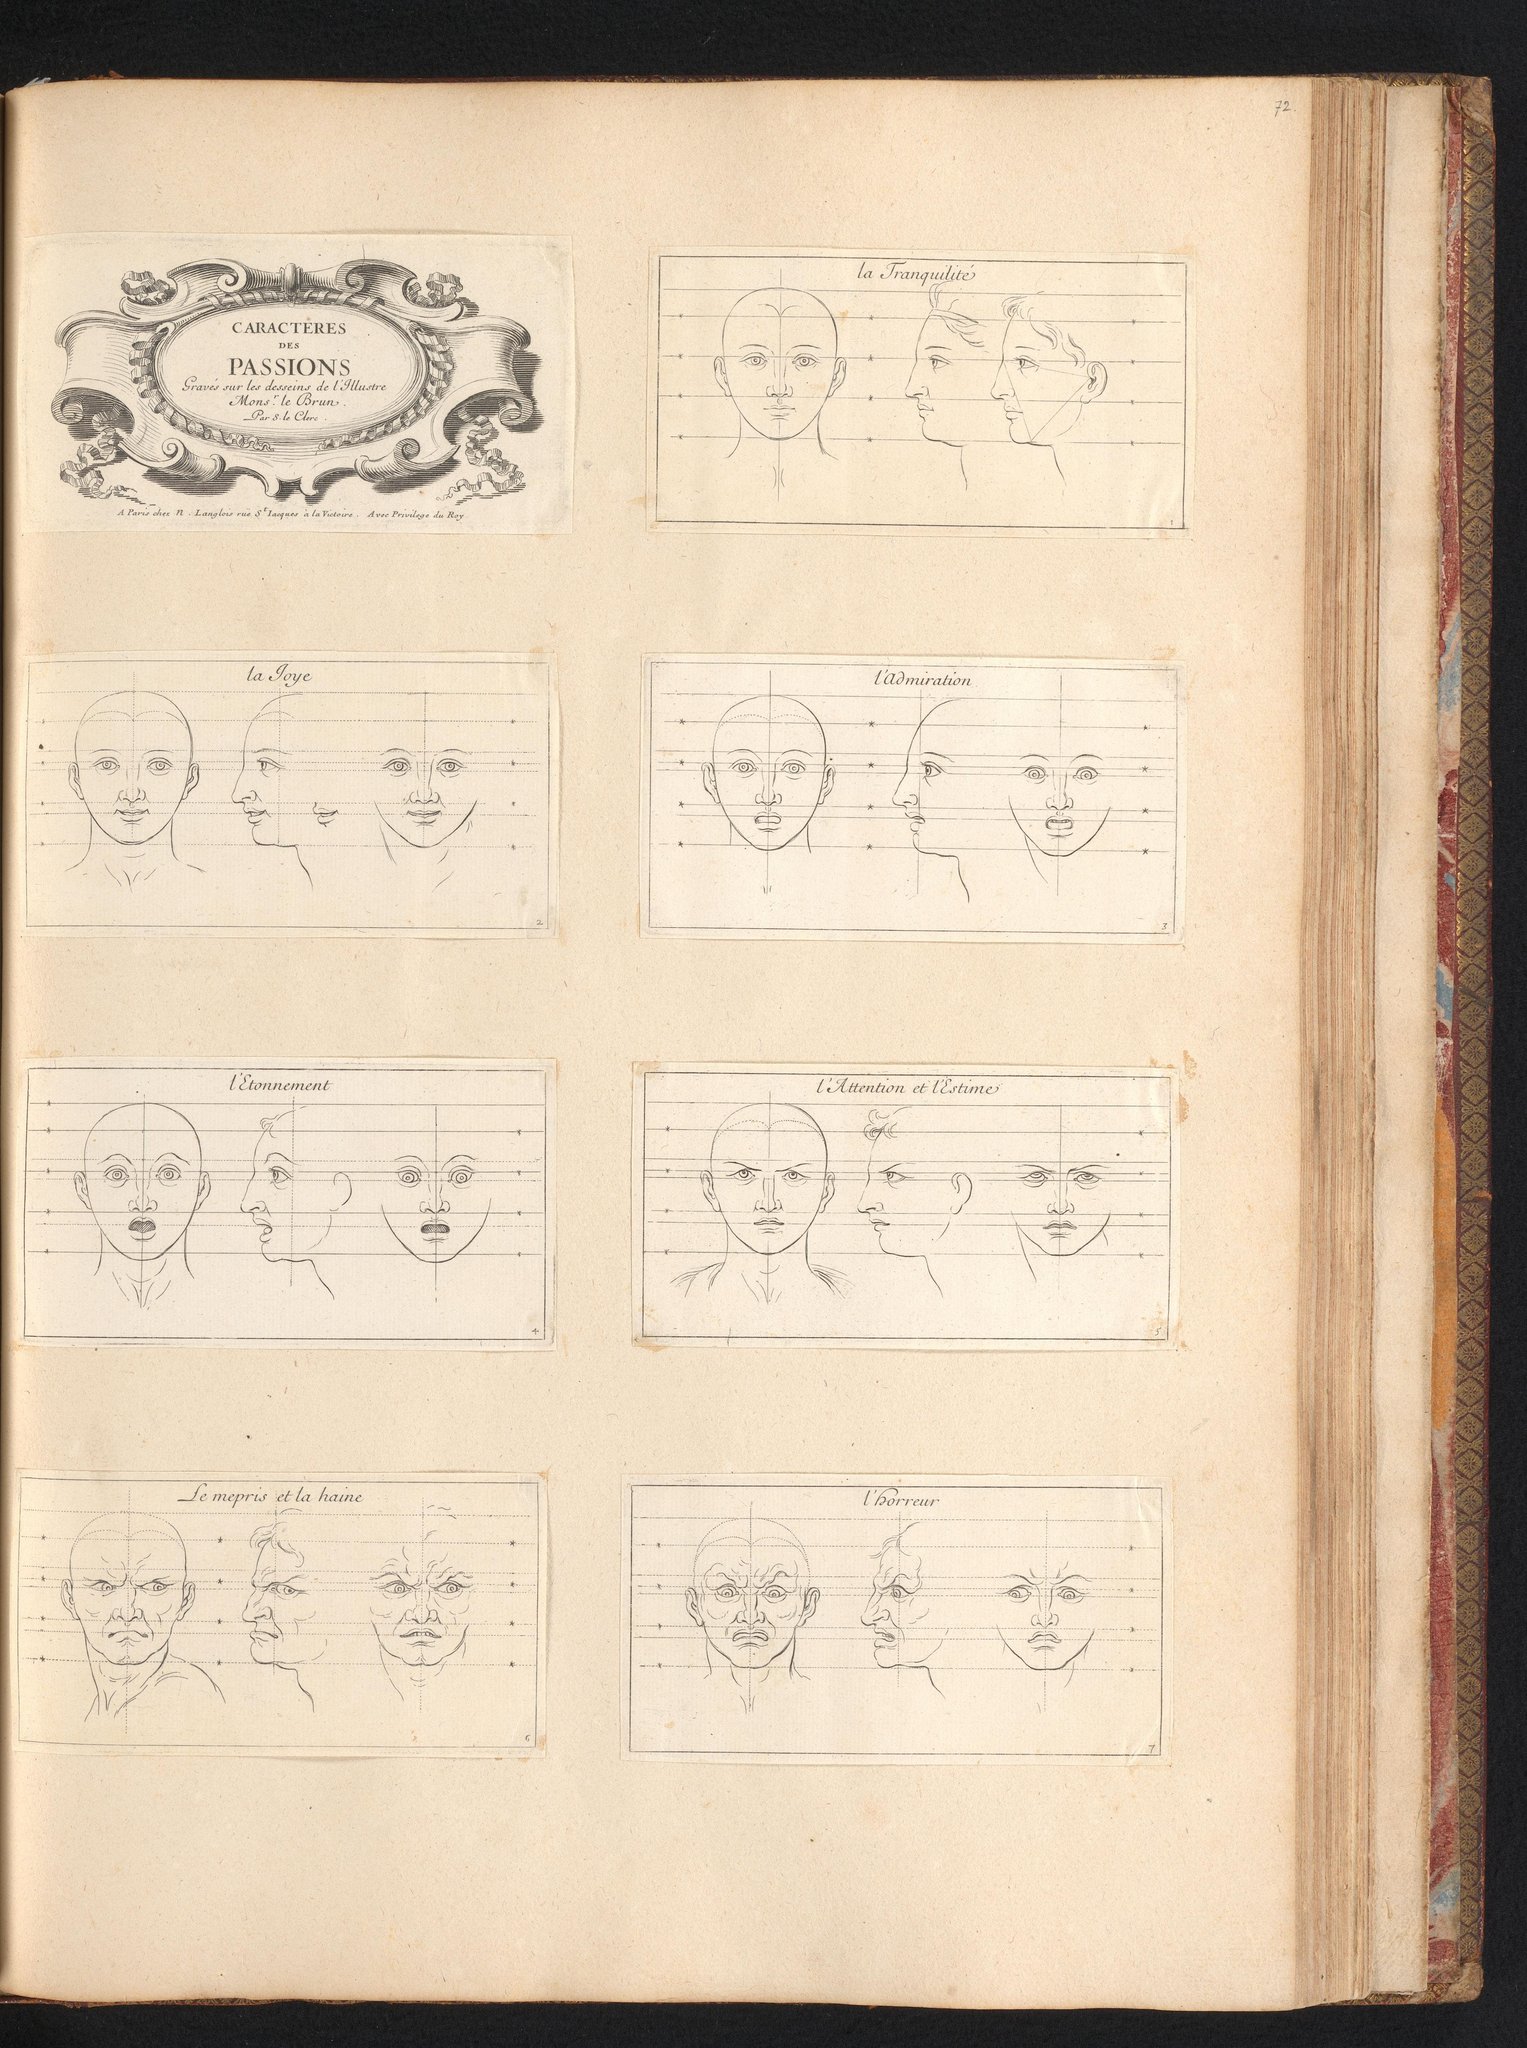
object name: album leaf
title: Caracteres des Passions (...)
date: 1692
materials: paper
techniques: engraving, etching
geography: paris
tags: model-books ~ implements of painter, morphology of facial expression, tools, implements of draughtsman, physiognomy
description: Titelprent en zeven tekenvoorbeelden van verschillende gezichtsuitdrukkingen en emoties. Alle prenten, behalve de titelprent, zijn rechtsonder genummerd van 1 t/m 7 en voorzien van een beschrijving van de in prent gebrachte uitdrukking of emotie. Deze acht prenten maken deel uit van een album.